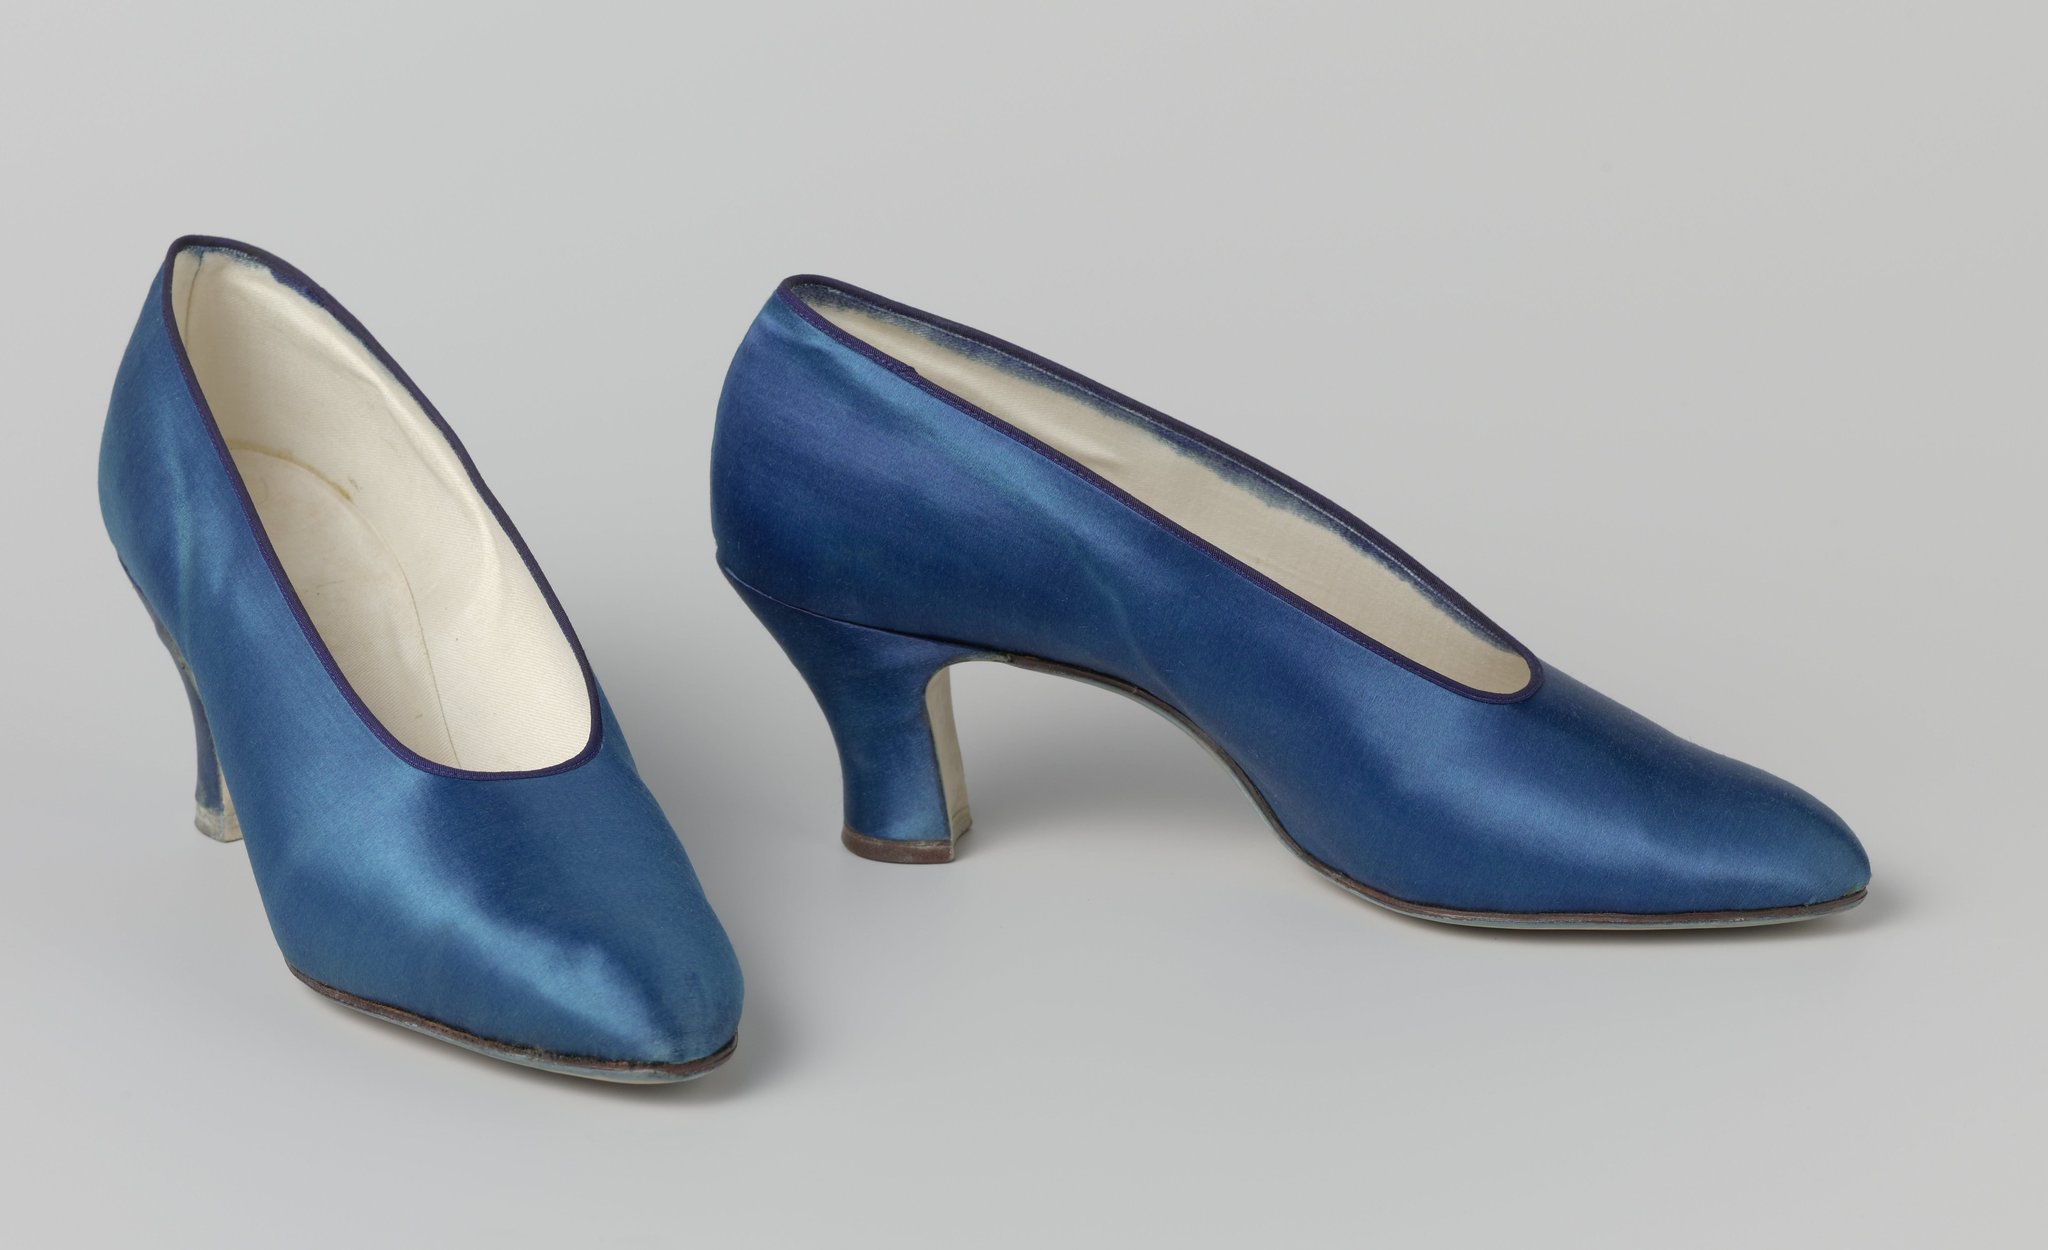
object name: pump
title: Schoen, van kobaltblauwe satijn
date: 1930-1935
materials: leather, linen, textile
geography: western europe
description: Linker balschoenen van kobaltblauw satijn. Model: Pump, van één (voor)blad gesneden. Hoge, vrij grove hak. Adres: op rechter buitenzool een blindstempel in randje met boven een riempjesschoen en profil en onder B a t a (?) Fl 2,90.